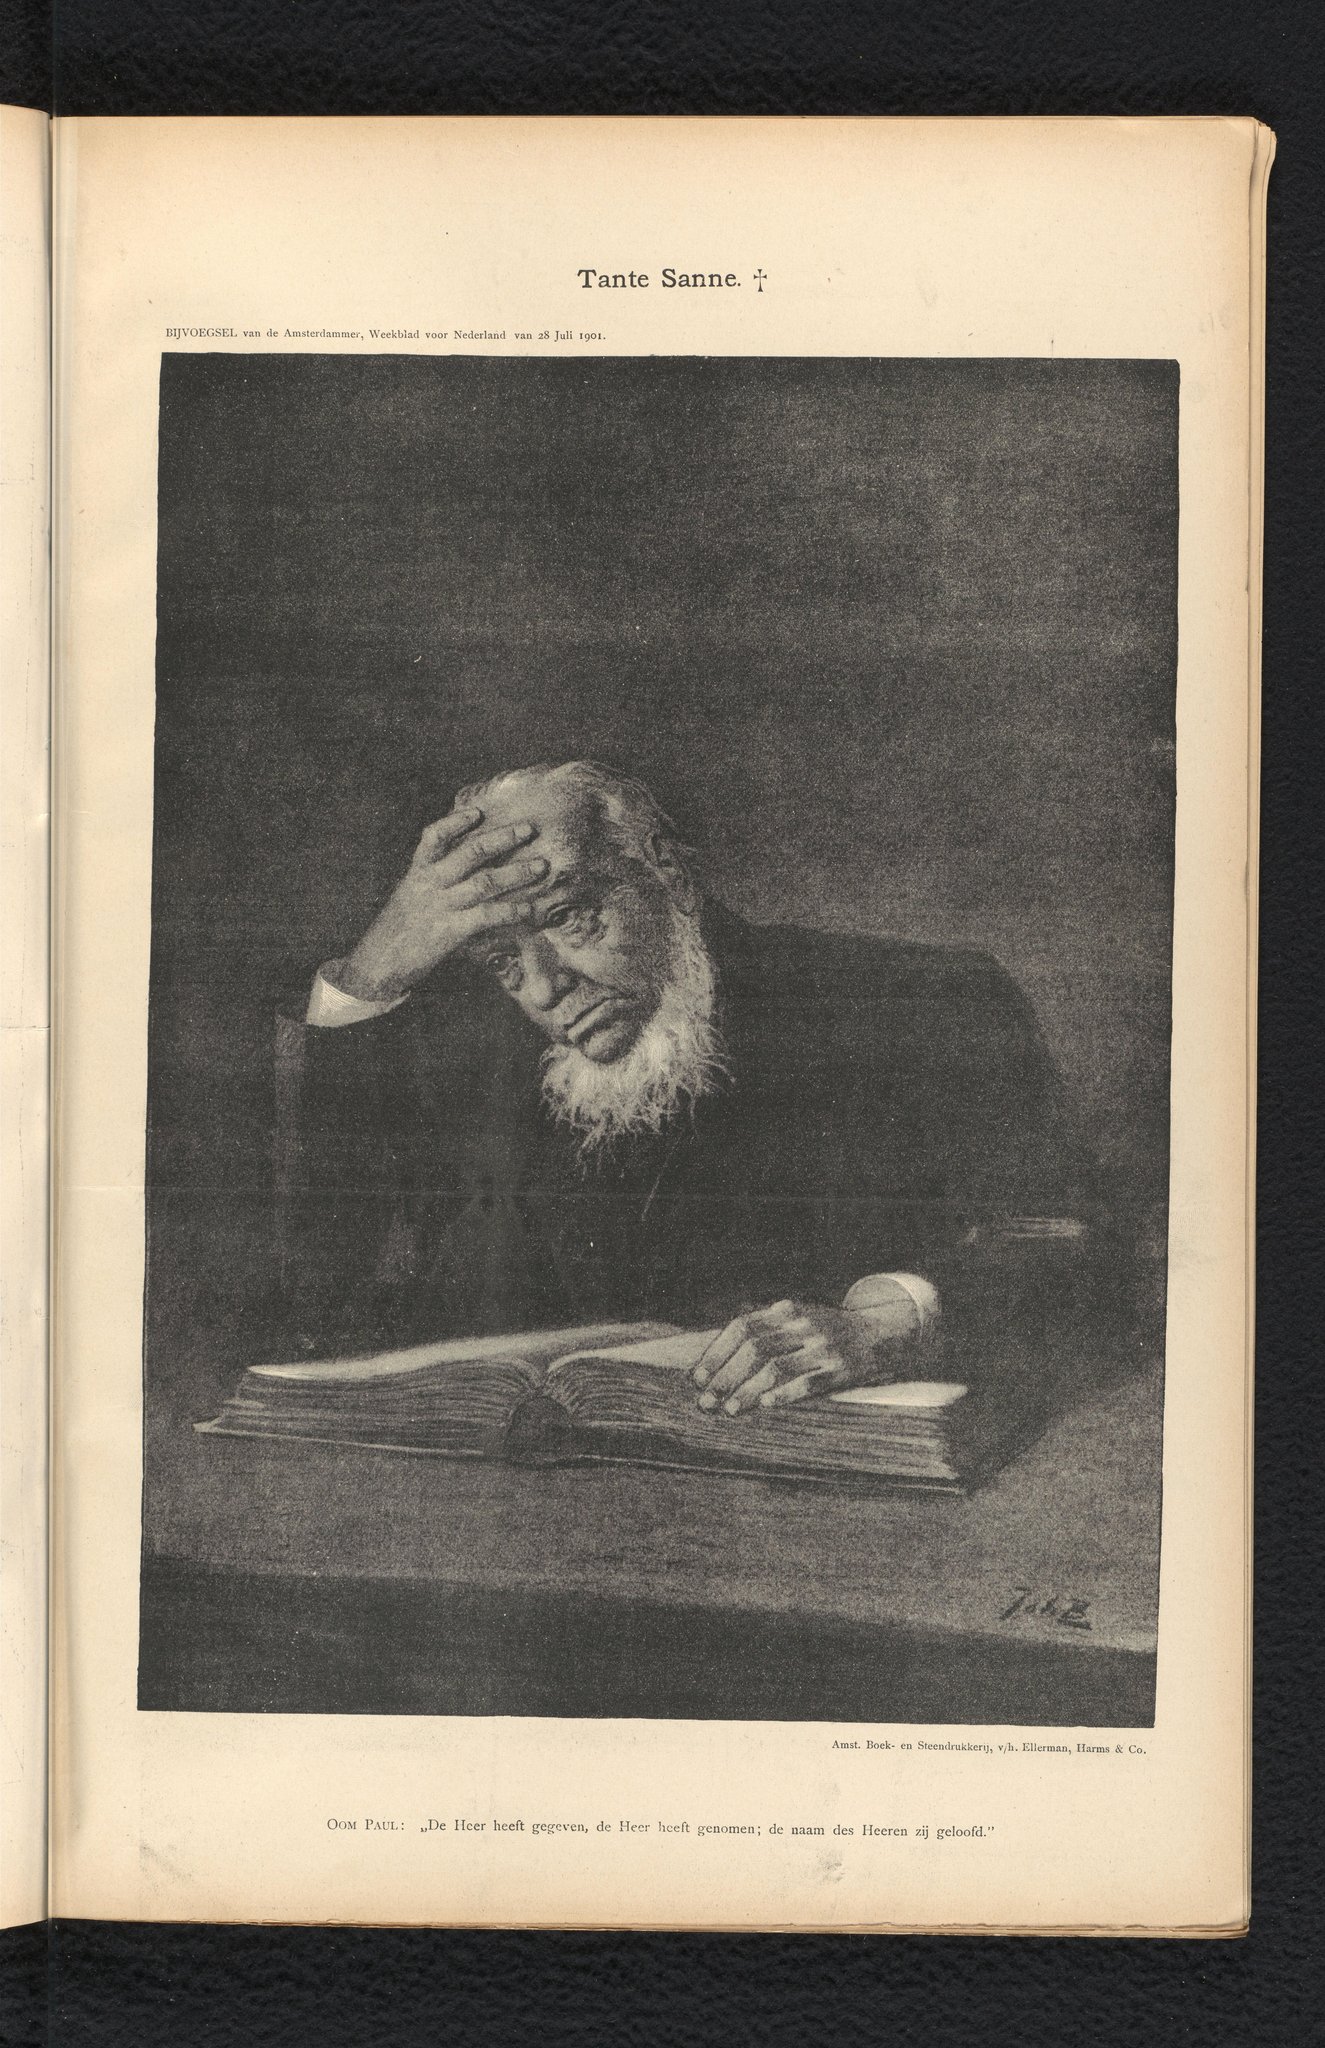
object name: photomechanical print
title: Tante Sanne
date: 1901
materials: paper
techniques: autotype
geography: amsterdam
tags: historical persons, reading the bible or other religious books, widower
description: President Paul Kruger zoekt troost in de Bijbel na het overlijden op 20 juli van zijn (tweede) echtgenote Gezina du Plessis (Tante Sannie).